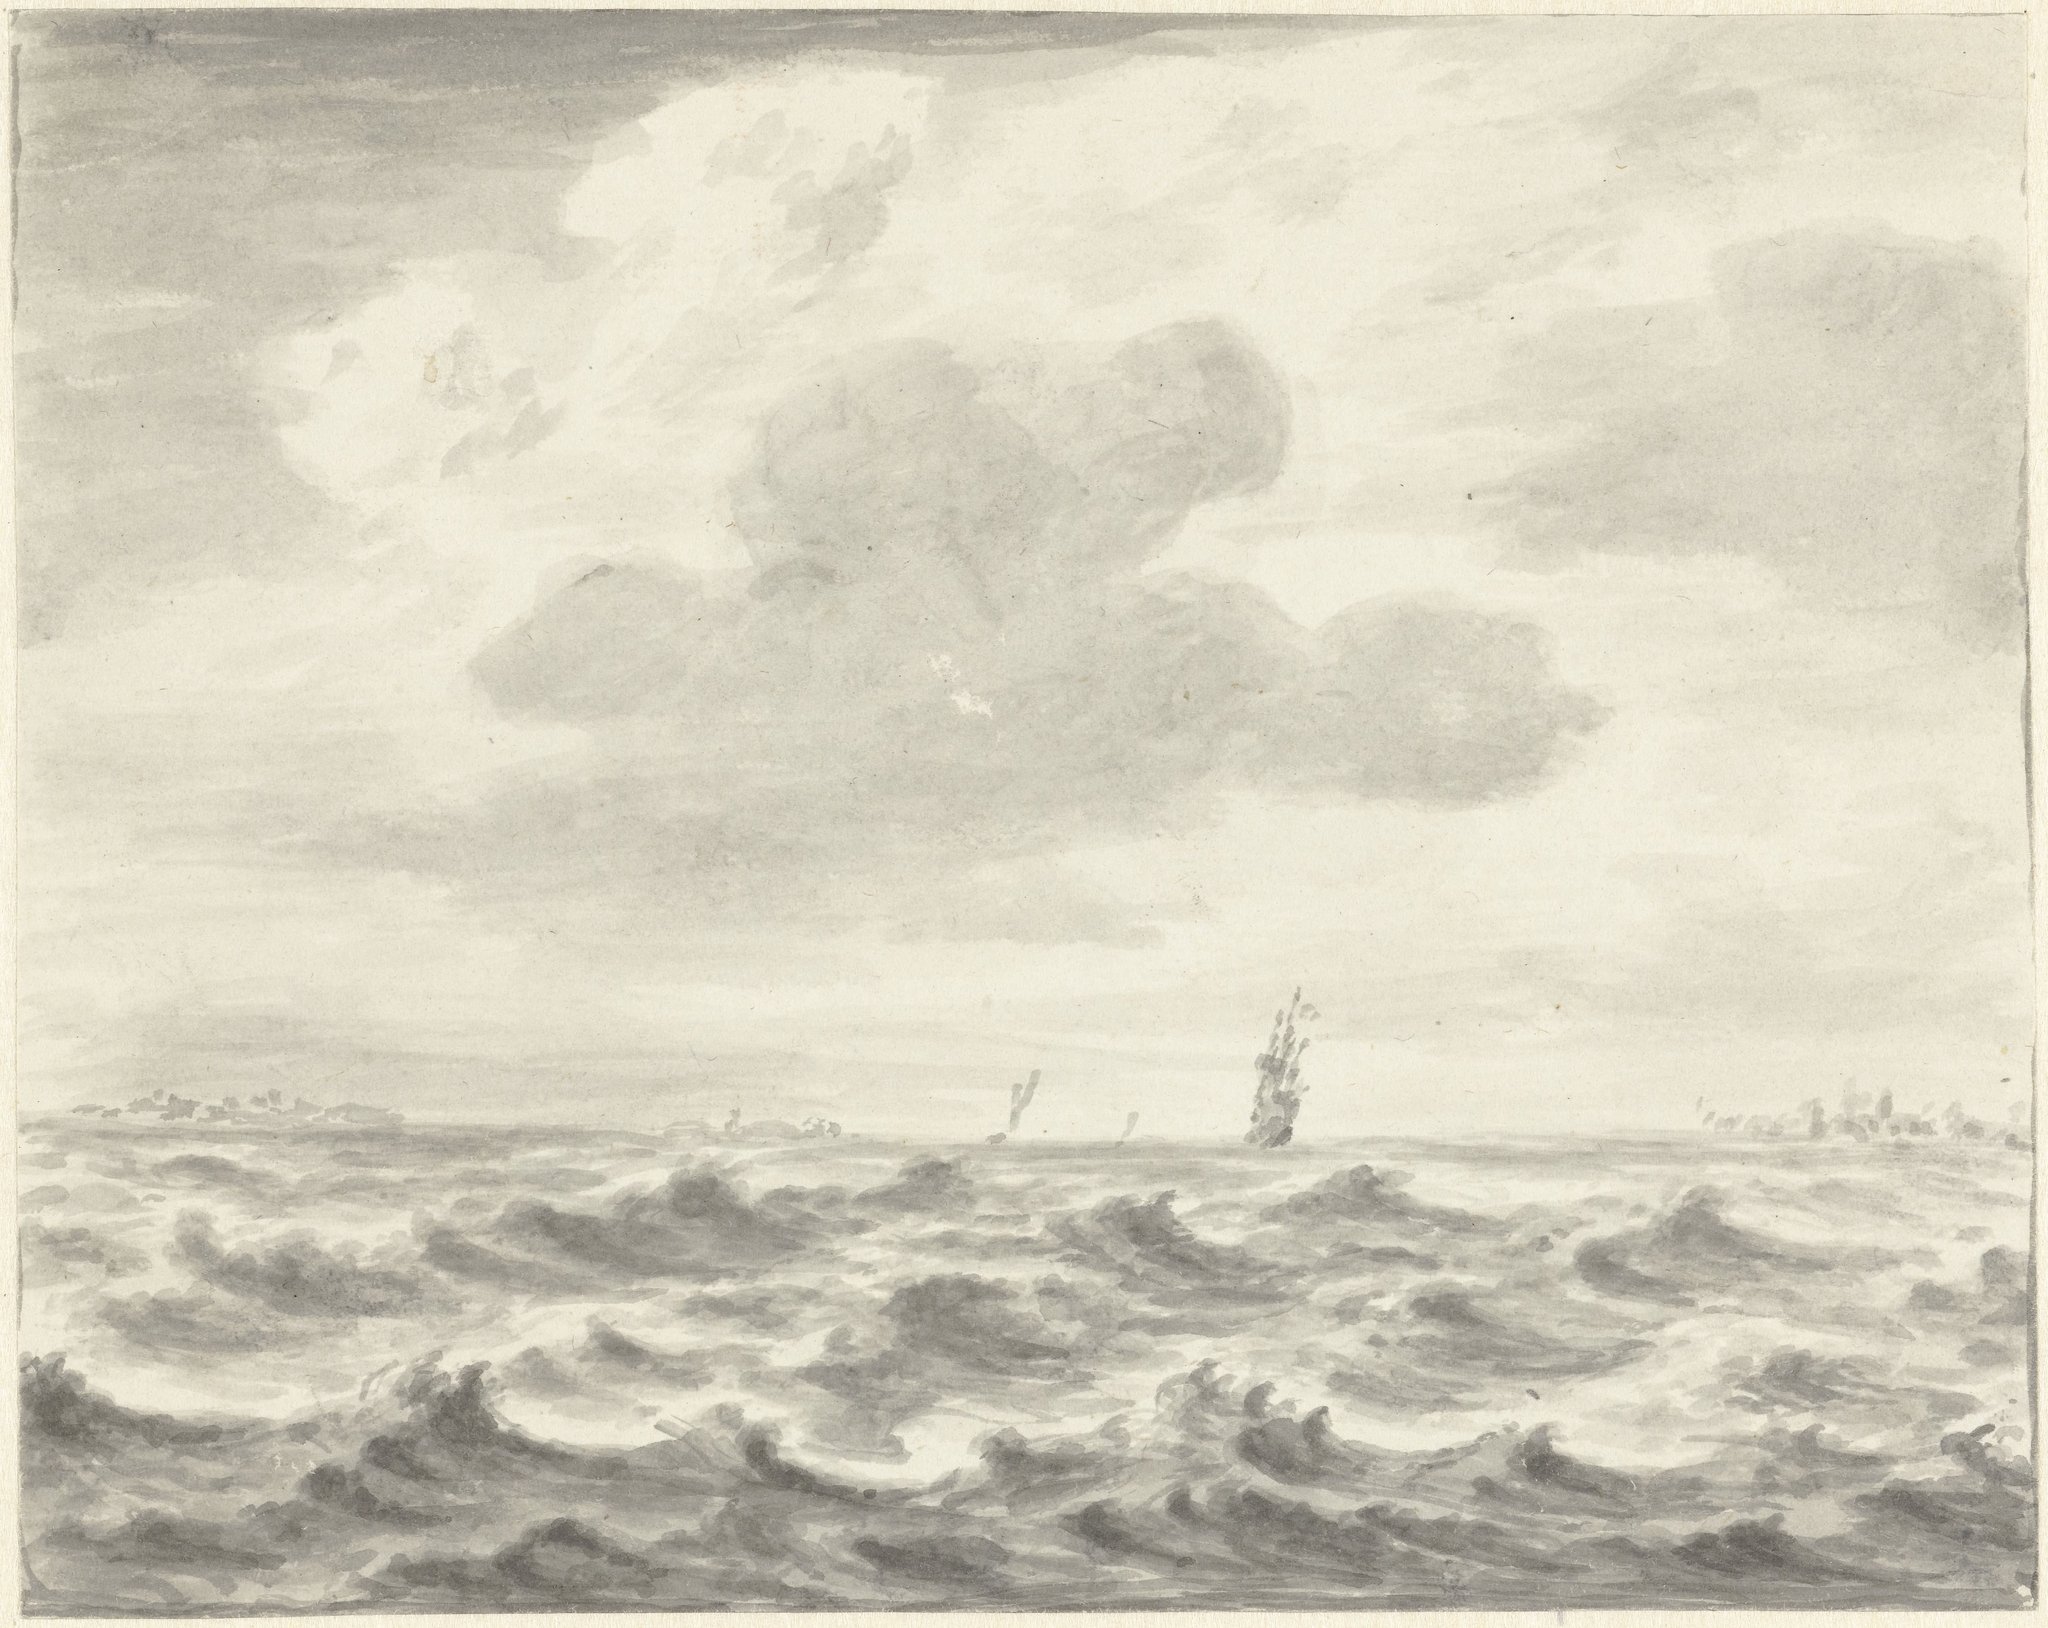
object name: drawing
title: Zeegezicht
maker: pieter idserts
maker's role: draughtsman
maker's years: 1698-1781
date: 1708-1781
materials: paper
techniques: brush